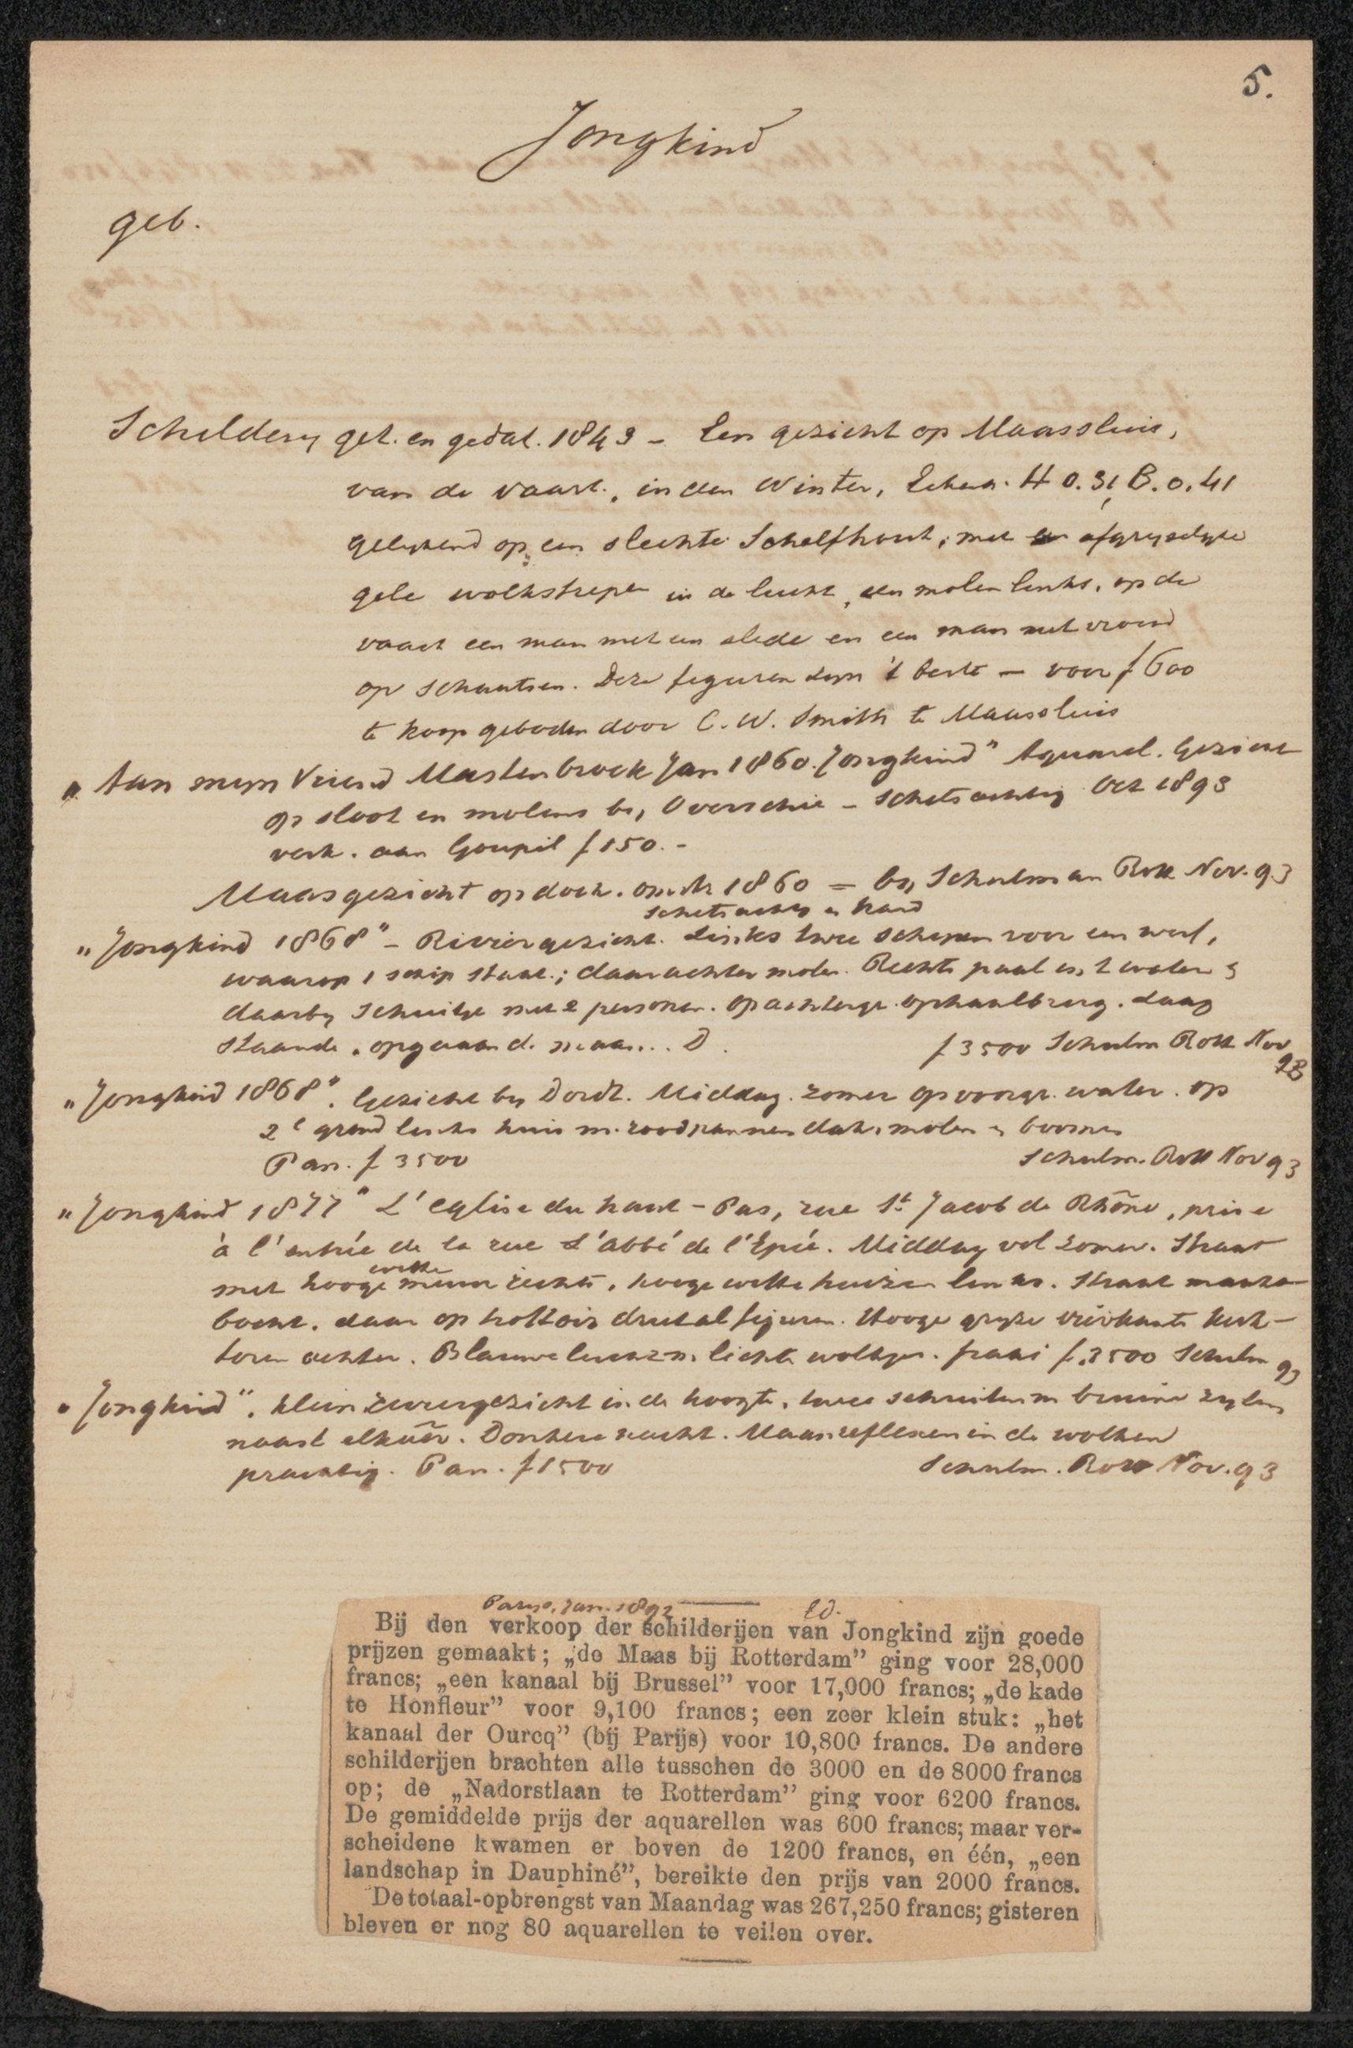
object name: aantekening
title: Aantekening betreffende Johan Barthold Jongkind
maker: Anonymous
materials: ink, paper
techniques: pen, writing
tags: painter, print maker, draughtsman, johan barthold jongkind, art trade, art shop, painting (including book-illumination, miniature-painting), money